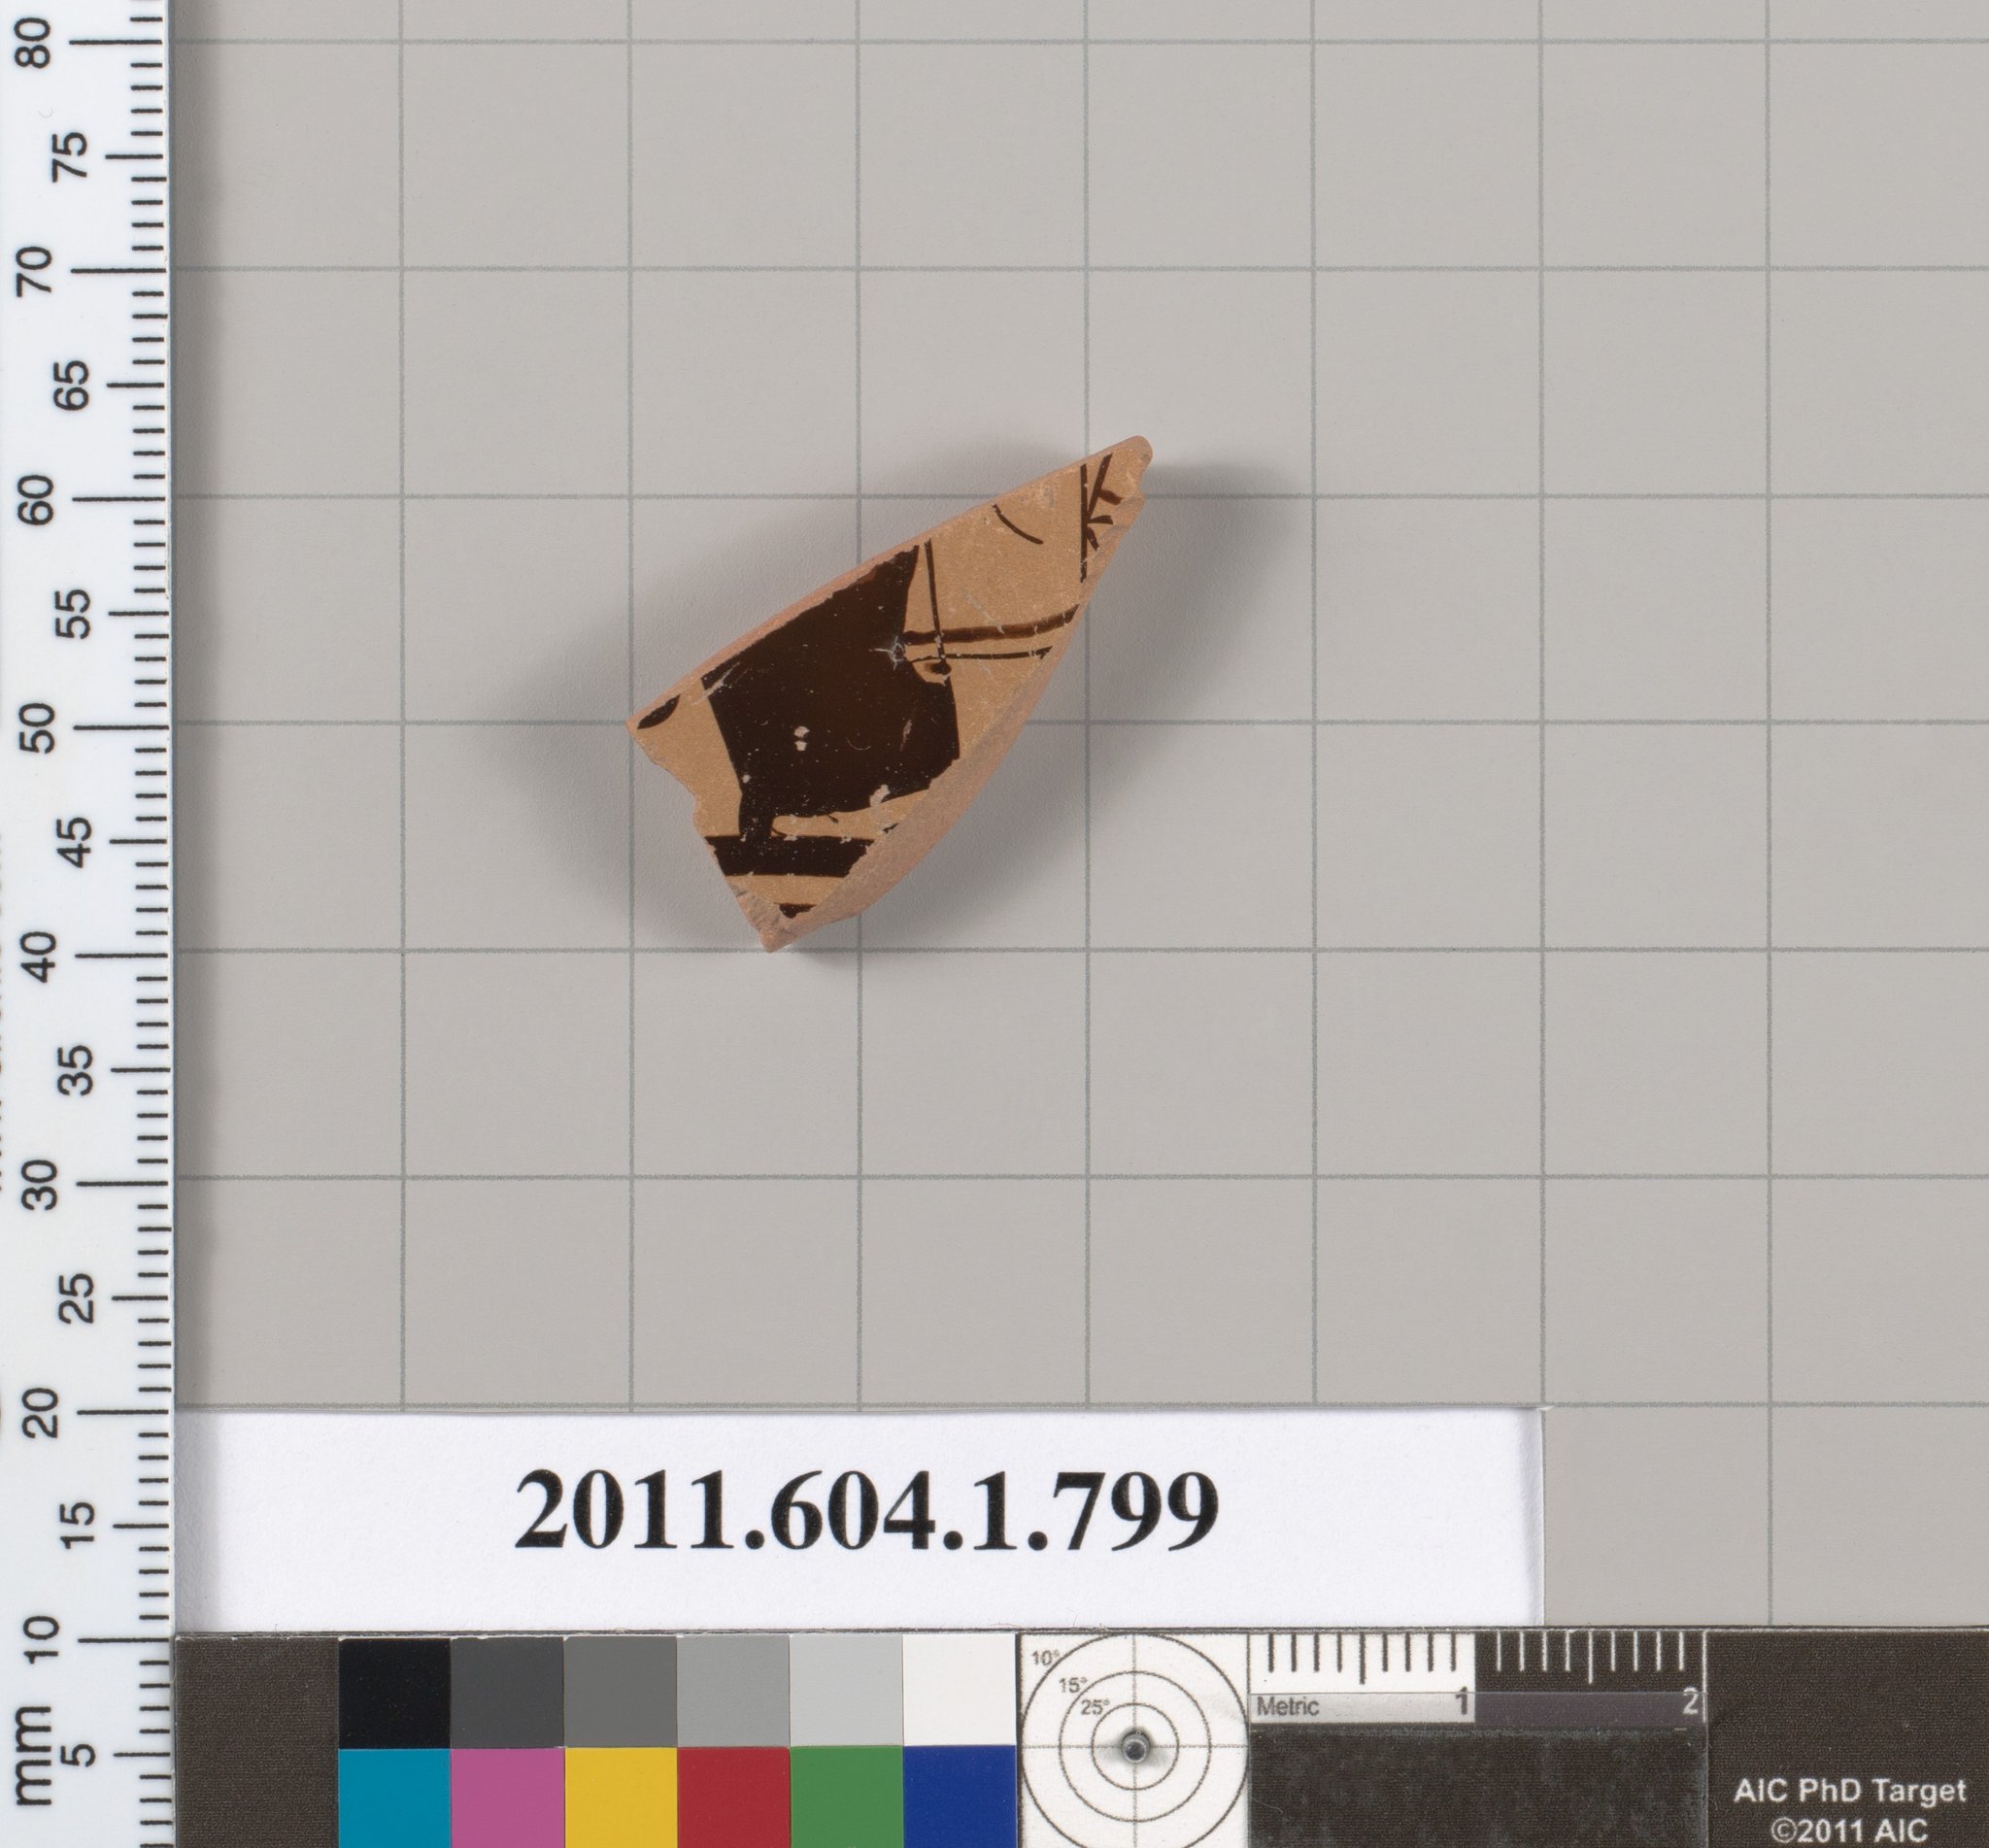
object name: kylix fragment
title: Terracotta fragment of a kylix (drinking cup)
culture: greek, attic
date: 475-451 BCE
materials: terracotta